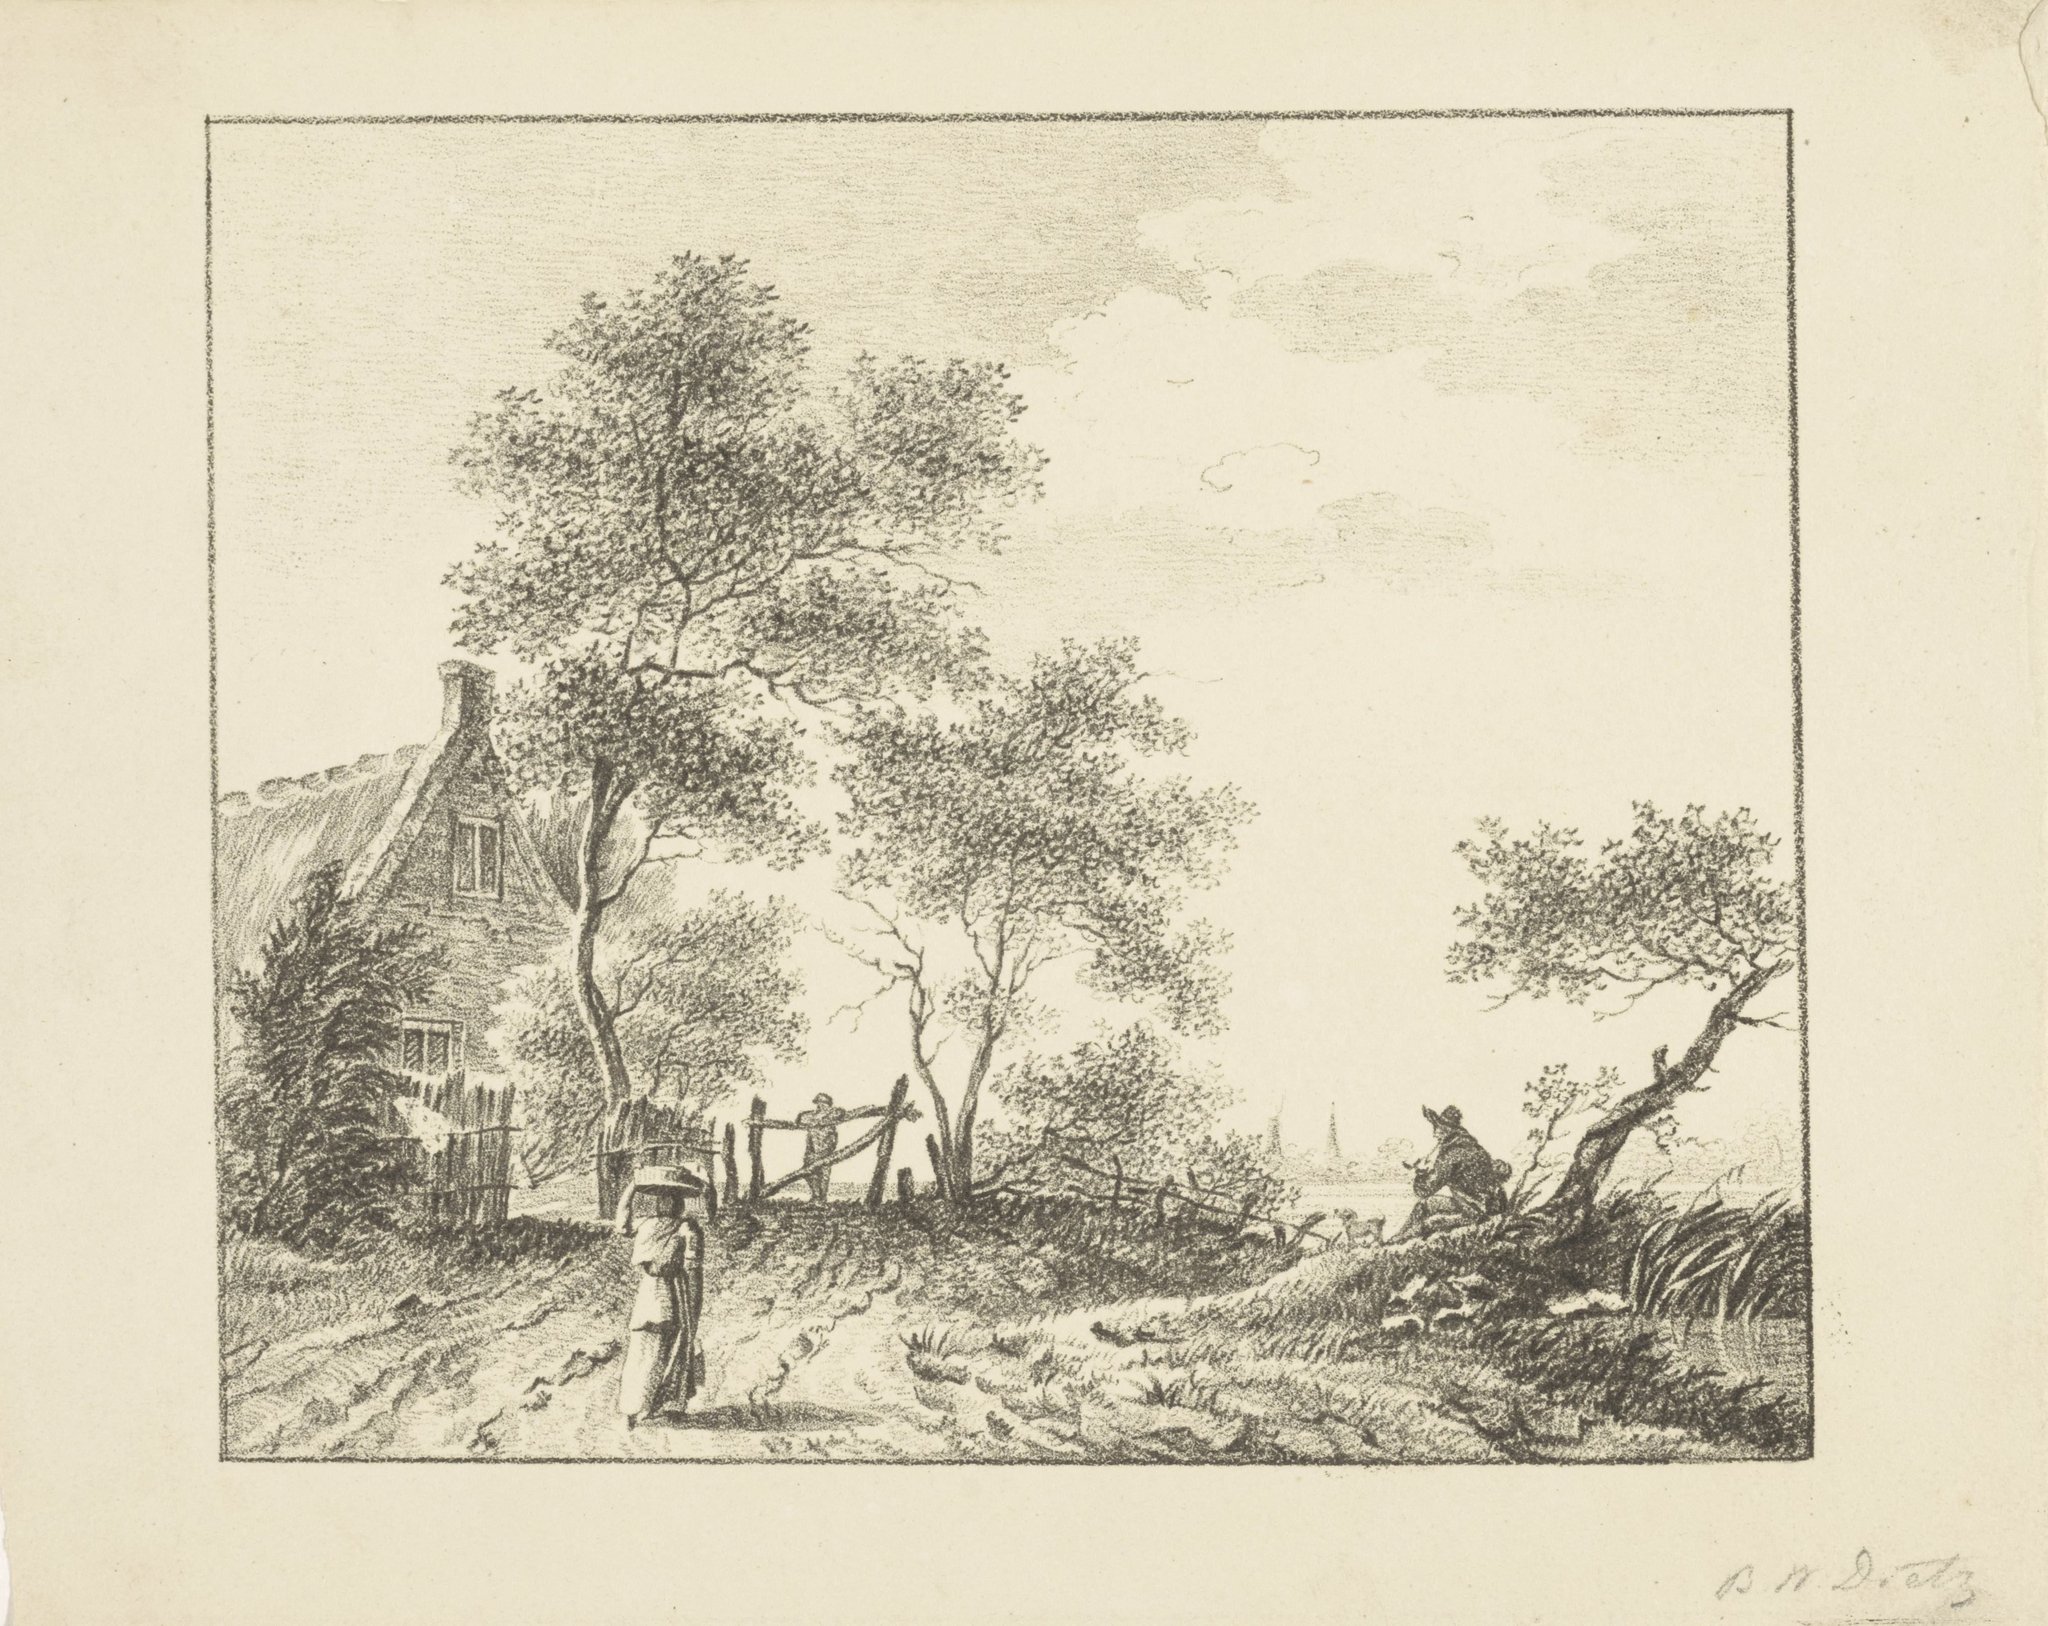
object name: print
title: Landschap met vrouw met mand op het hoofd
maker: barentie willem dietz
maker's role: print maker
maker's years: 1793-1864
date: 1817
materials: paper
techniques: lithograph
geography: arnhem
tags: landscapes (+ landscape with figures, staffage), farm or solitary house in landscape, carrying something on the head or on the shoulders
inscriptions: collector's mark: Lugt 2228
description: De vrouw loopt over een zandweg richting een huis. Rechts zit een man met een hond onder een boom. Een derde figuur leunt op een hekwerk aan het einde van de weg.